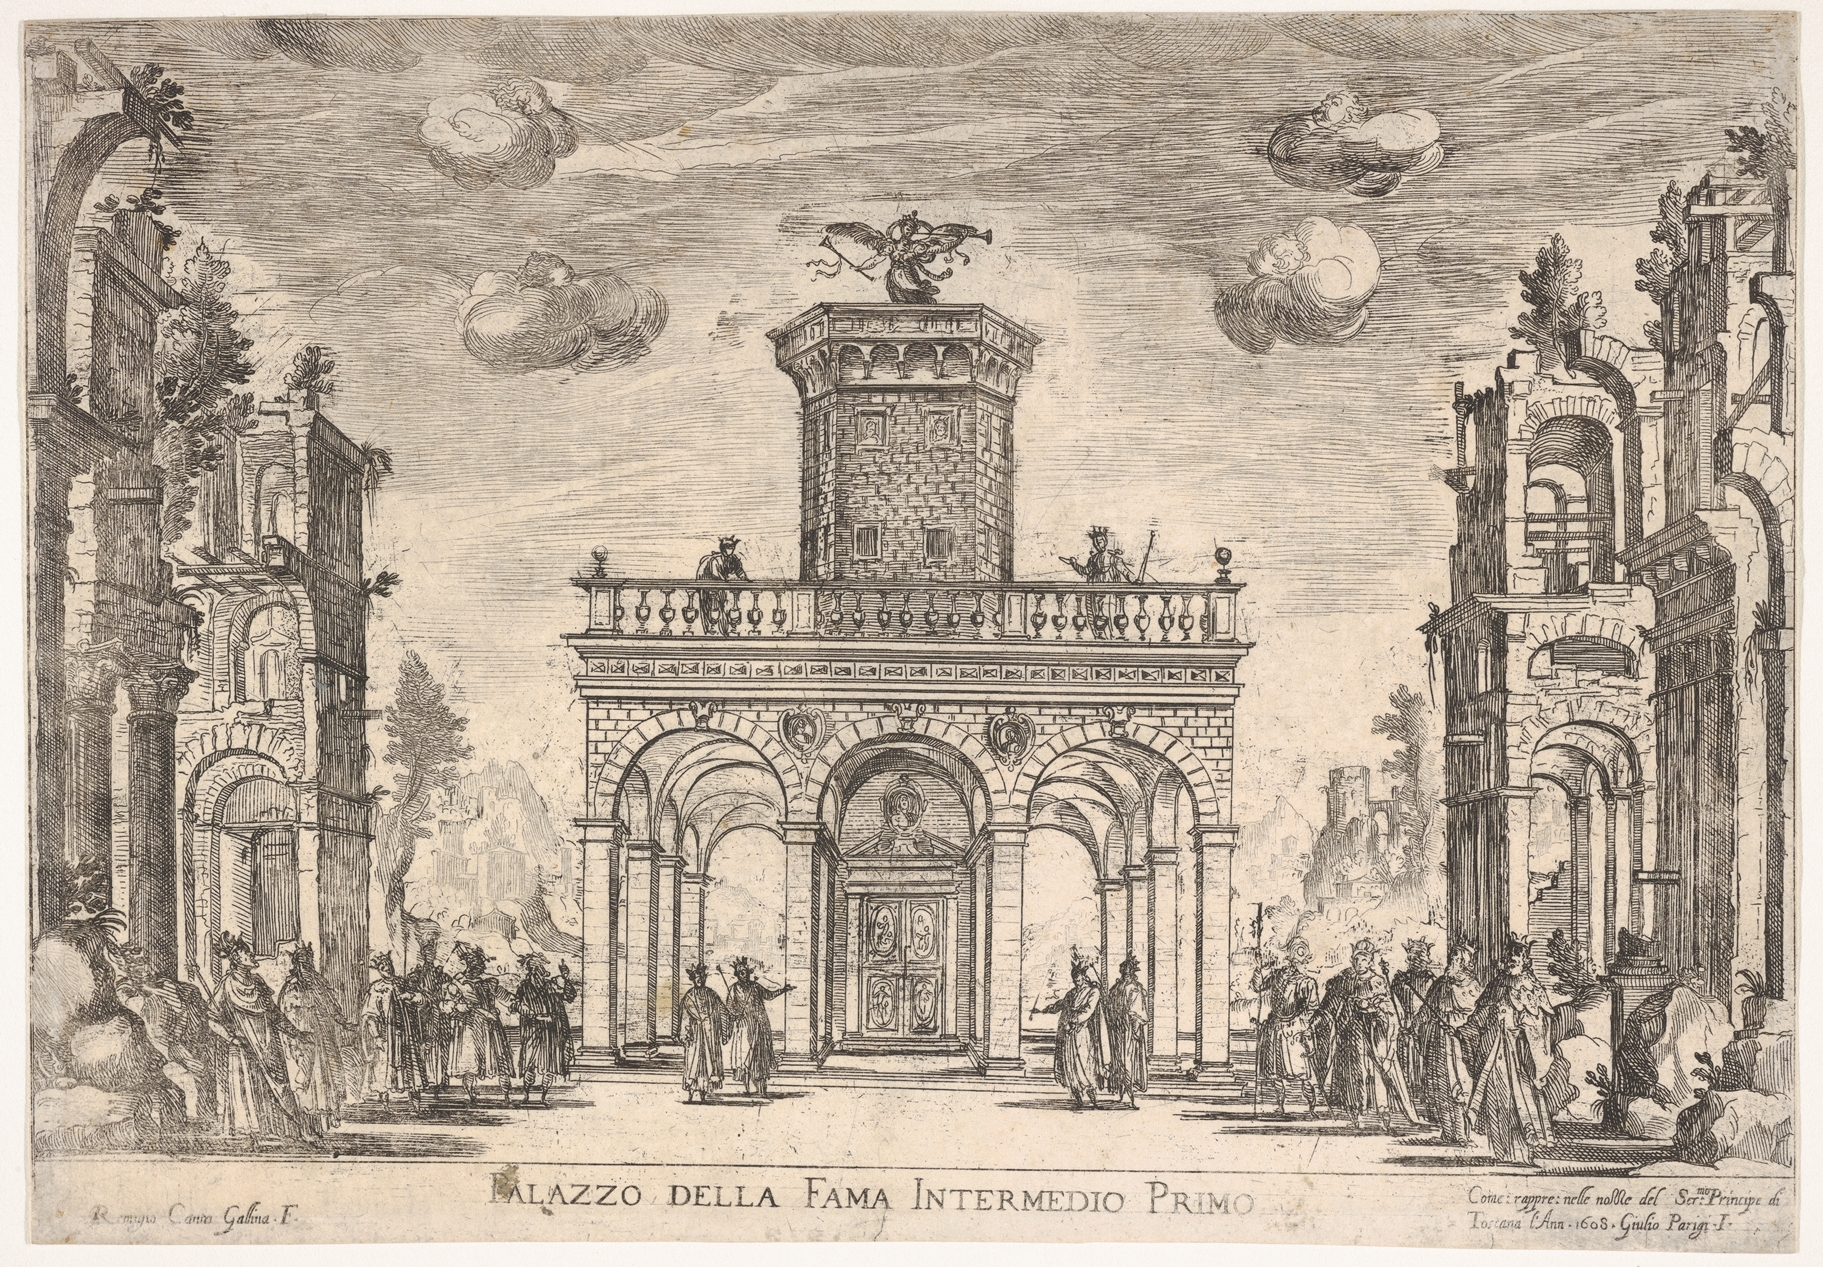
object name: print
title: First interlude: palace of fame (Intermedio sesto: palazzo della fama), from "Seven Interludes for the wedding celebration of Cosimo de' Medici in Florence, 1608"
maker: remigio cantagallina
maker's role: artist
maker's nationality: italian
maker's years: 1582-1656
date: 1608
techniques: etching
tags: human figures,palaces